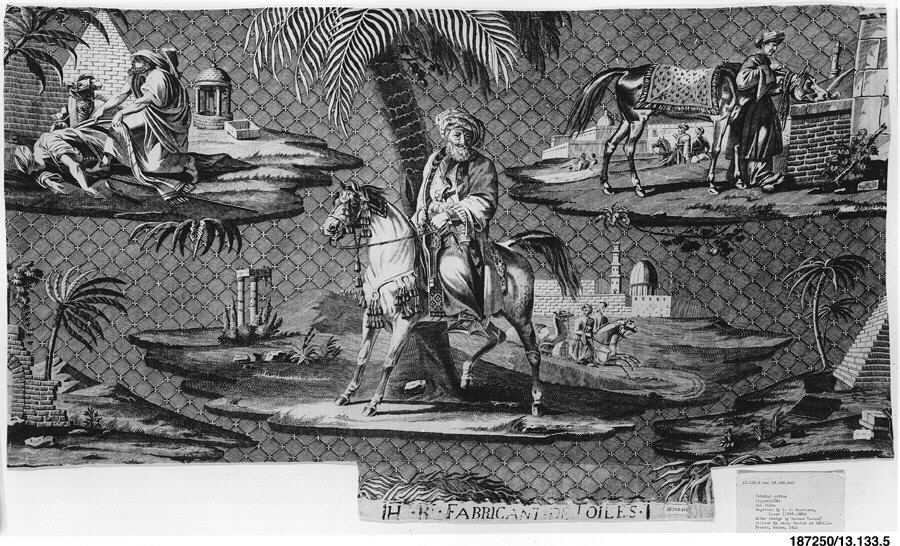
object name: piece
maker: louis-henri brevière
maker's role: designer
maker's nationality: french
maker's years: 1797-1869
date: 1820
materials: cotton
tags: men,horses,trees